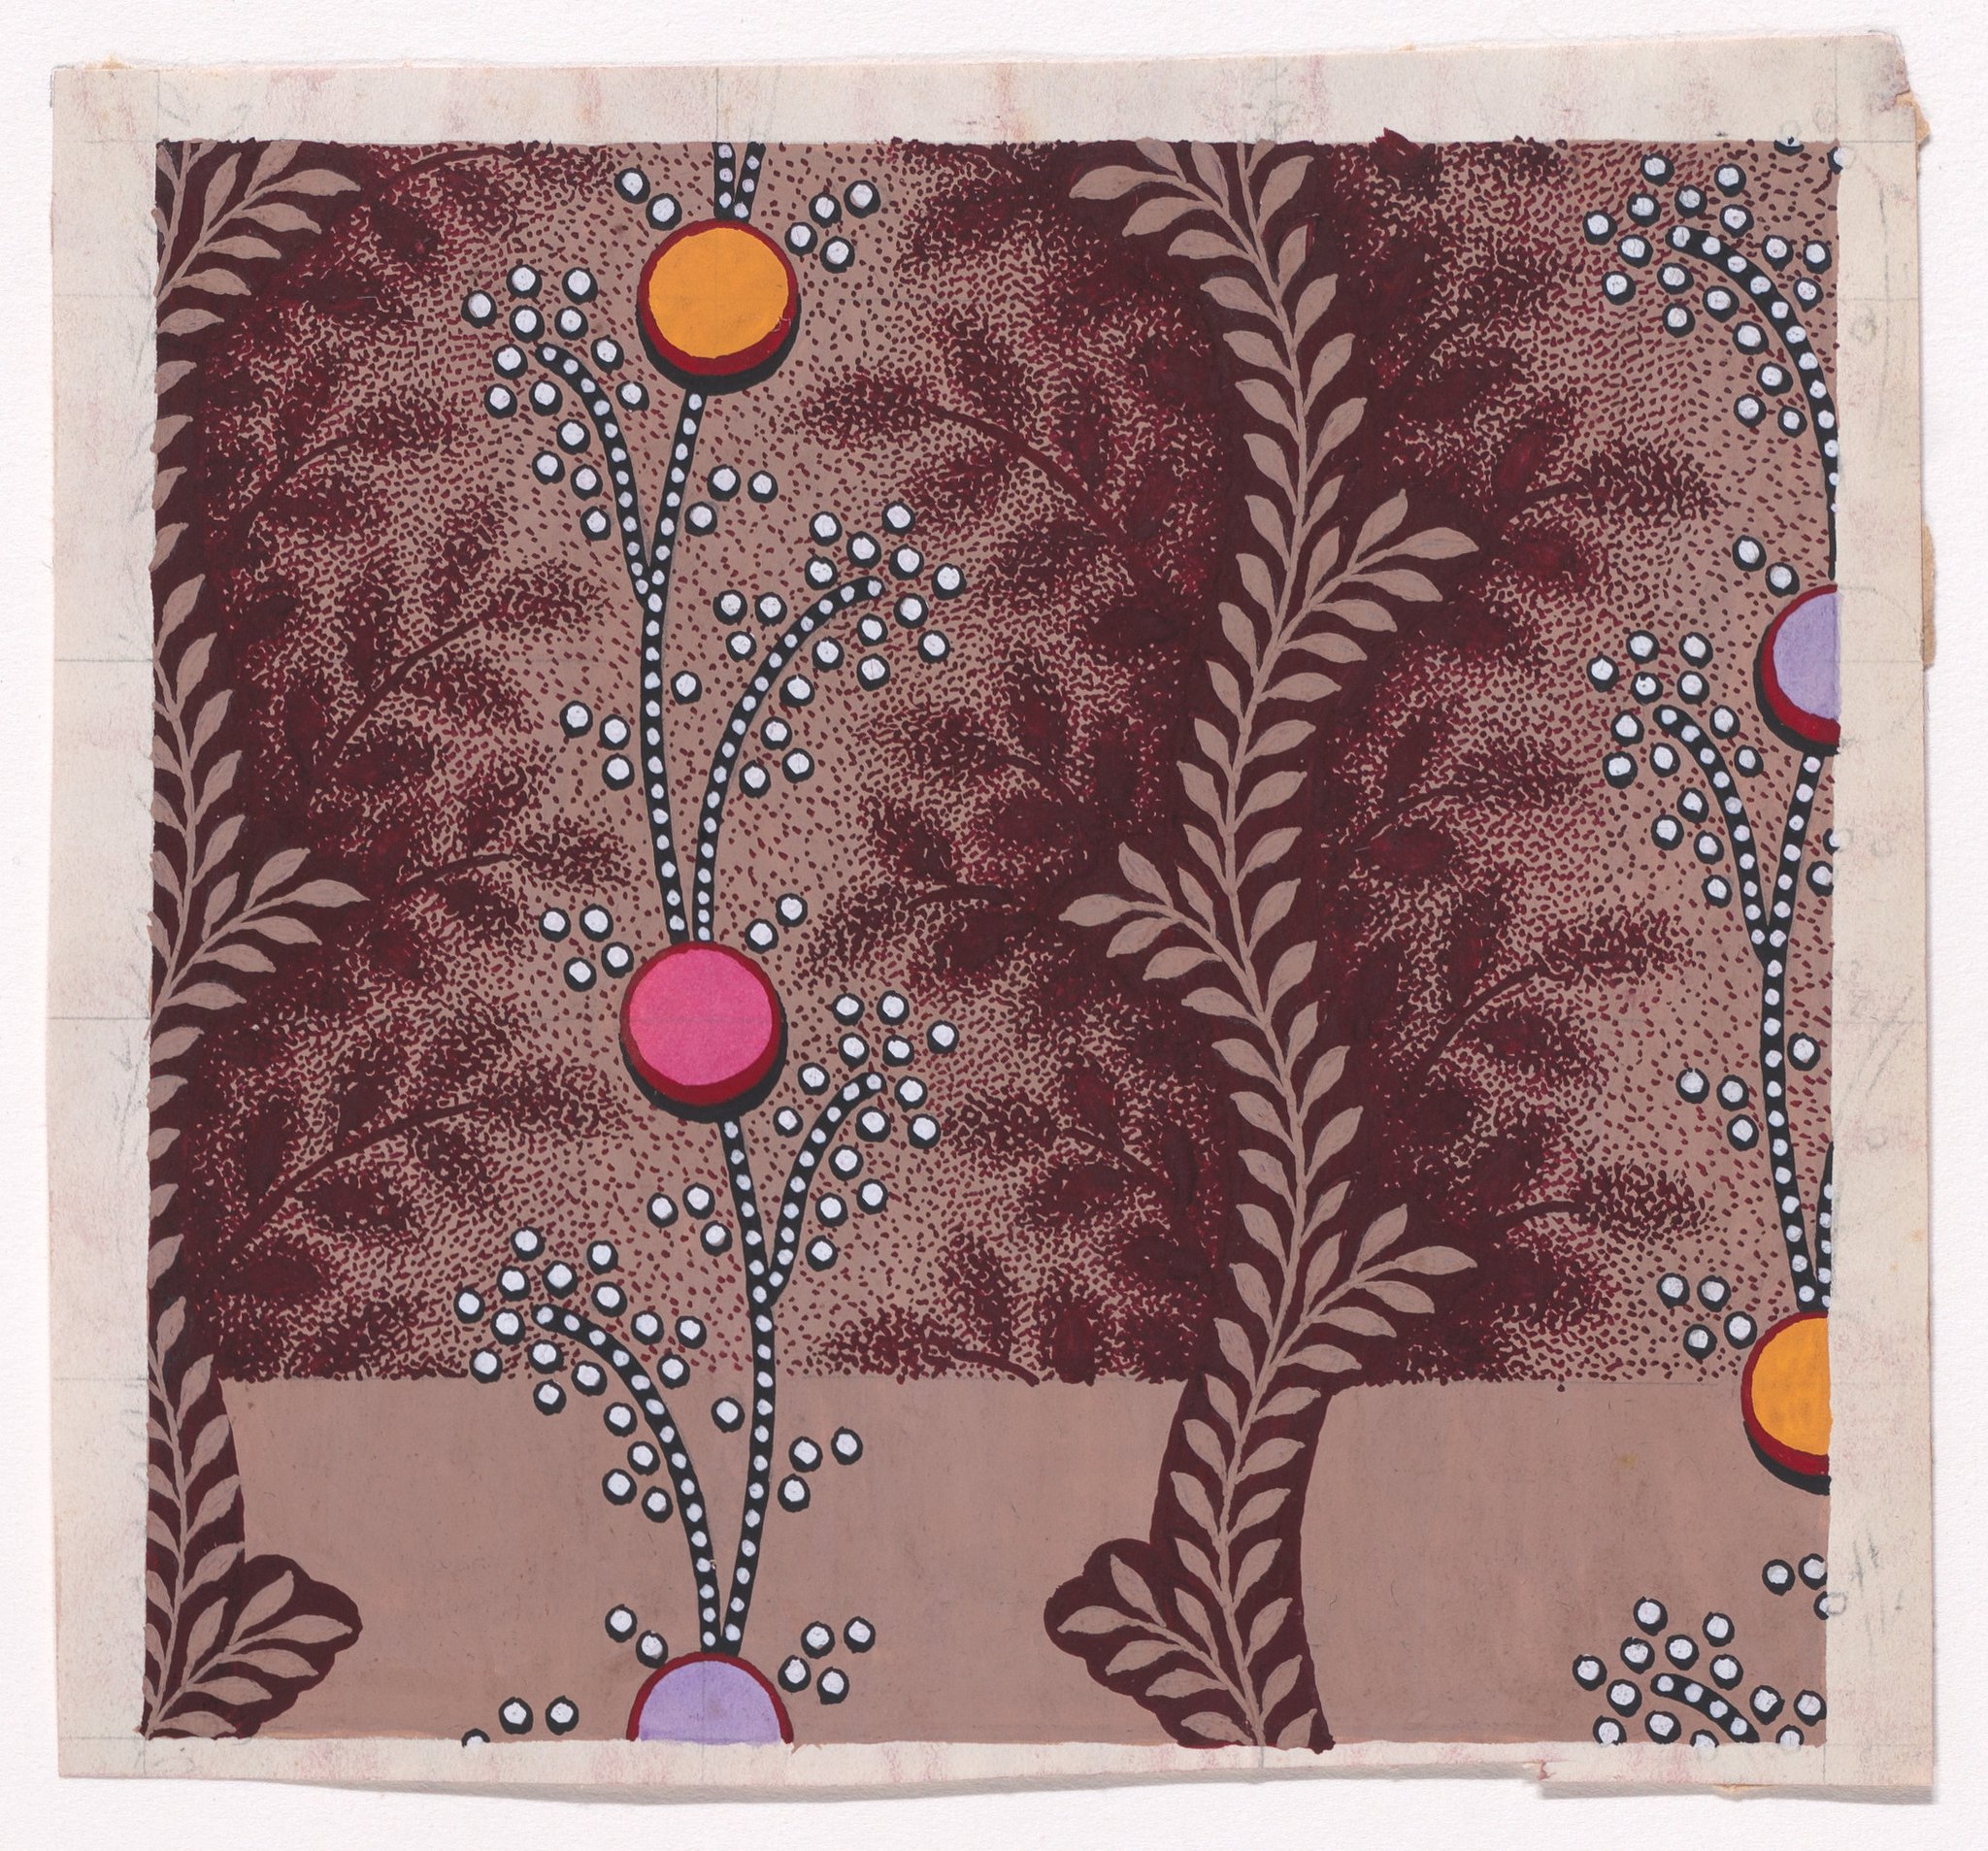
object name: drawing ornament architecture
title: Textile Design with Vertical Scrolls of Pearls with Circles Separated by Vertical Undulating Garlands of Stylized Leaves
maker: anonymous, alsatian, 19th century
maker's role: artist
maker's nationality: alsatian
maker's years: 1800-1900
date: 1840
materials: gouache